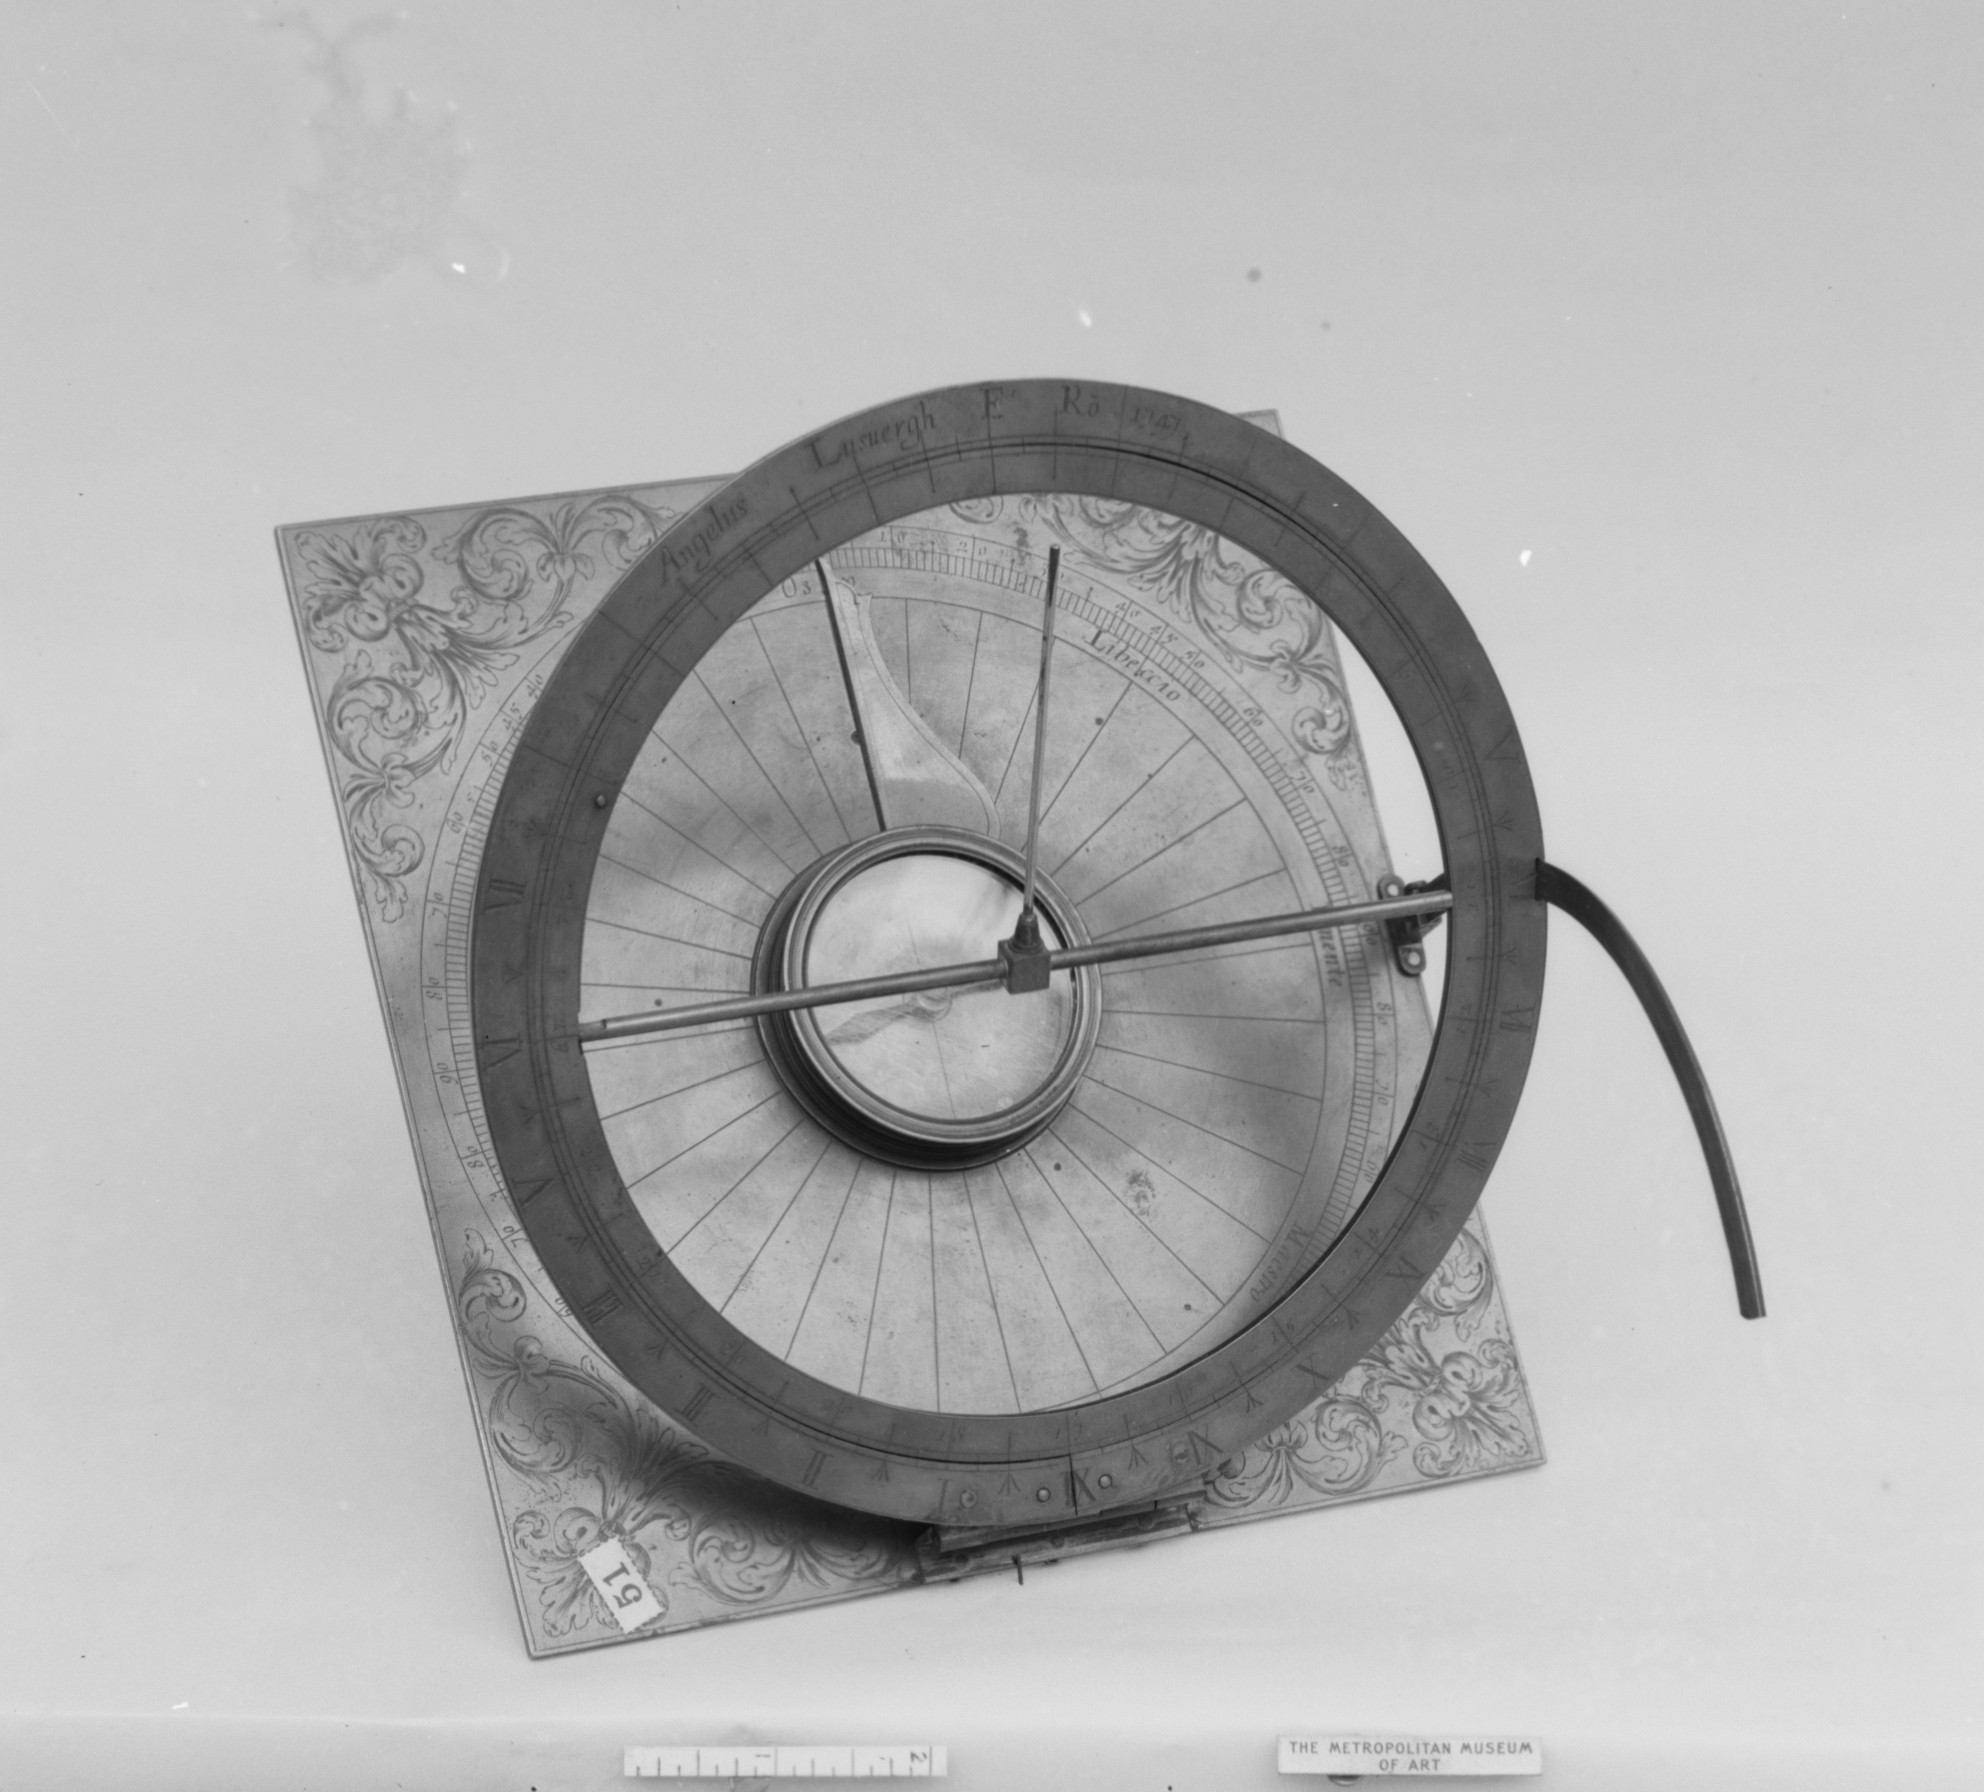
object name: portable equatorial sundial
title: Portable equatorial or equinoctial sundial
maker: angelus lusuergh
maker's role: maker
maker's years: 1700-1800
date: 1747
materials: brass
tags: sundials